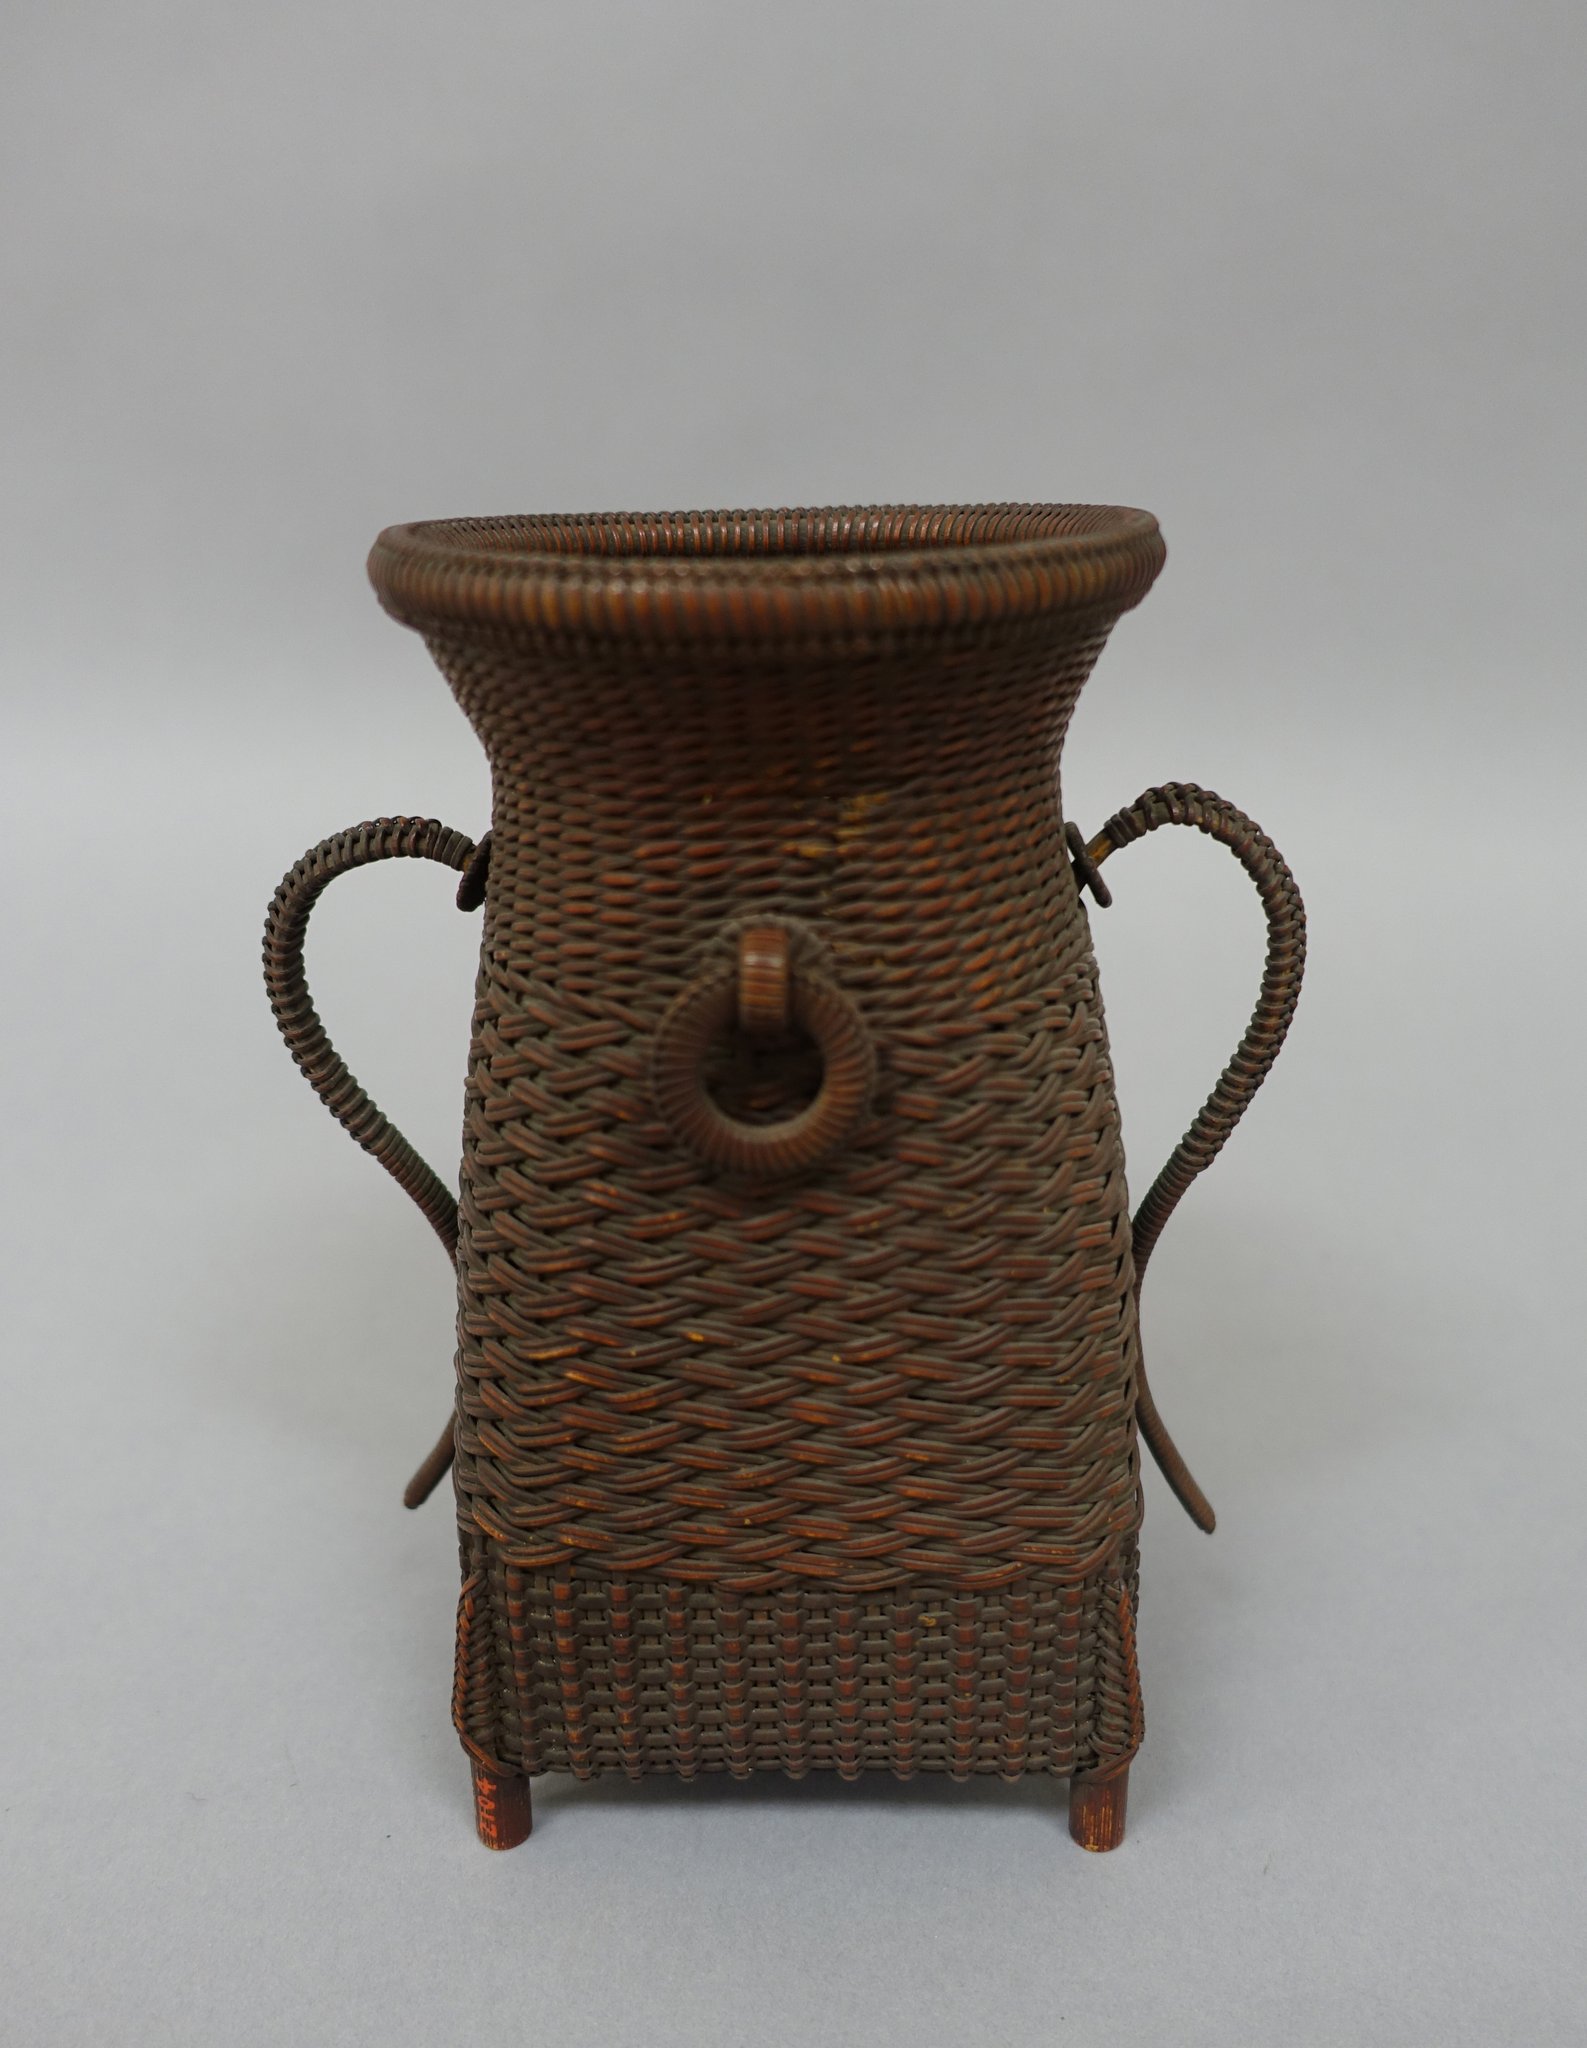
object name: basket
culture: japanese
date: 1801-1900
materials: rattan